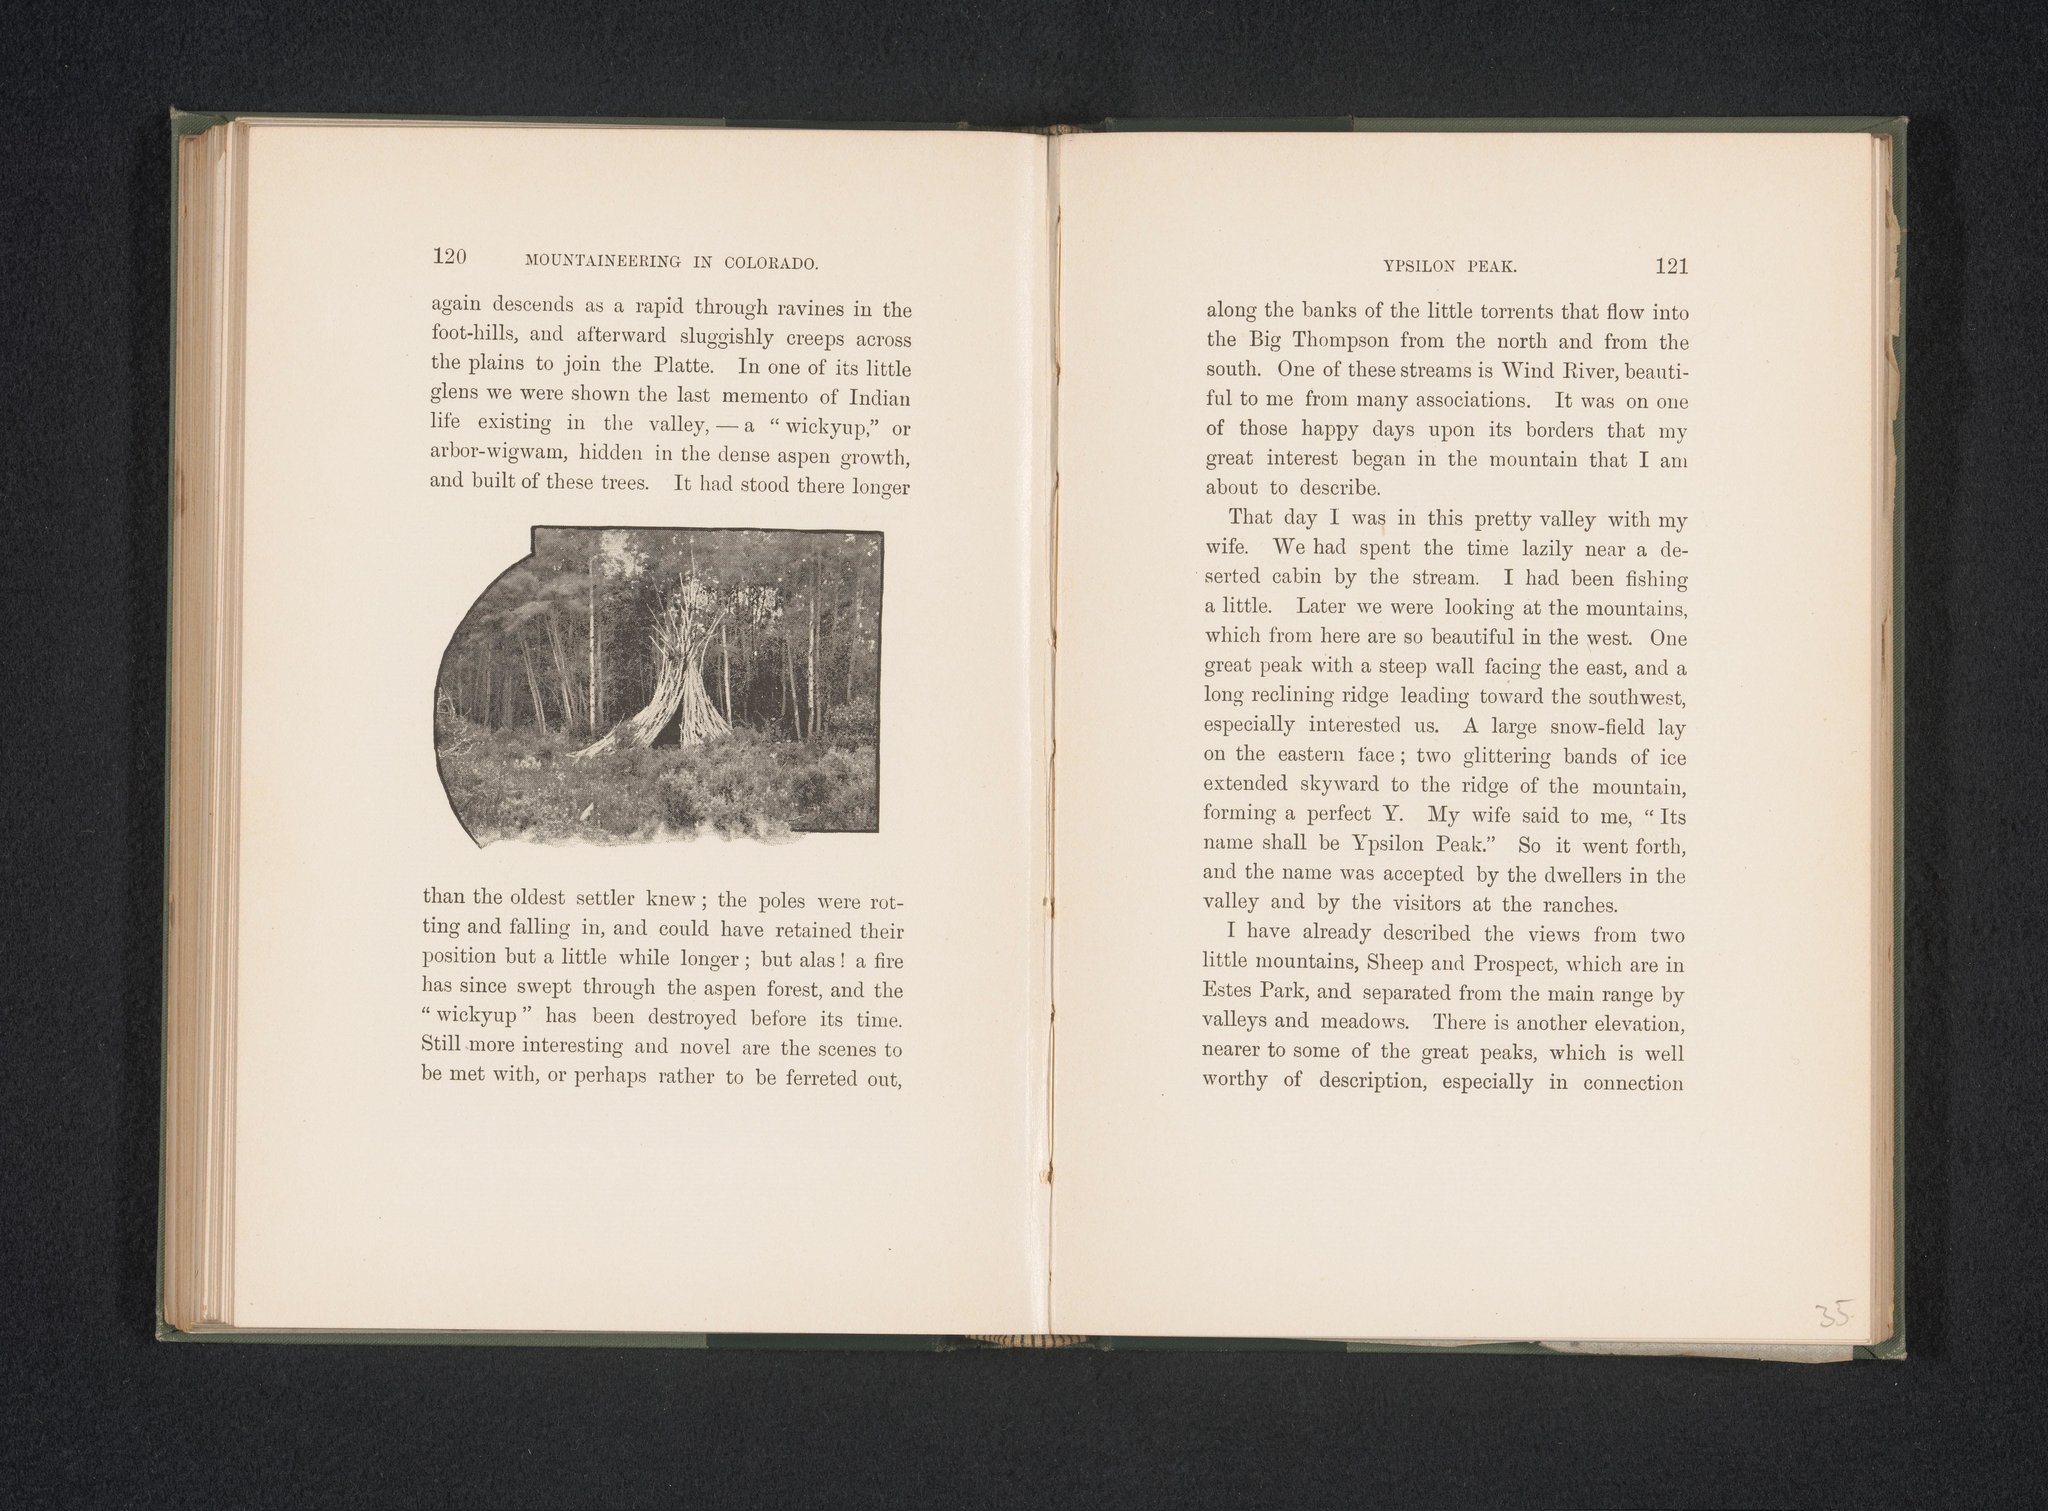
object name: photomechanical print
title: Gezicht op een bos met een wigwam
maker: frederick hastings chapin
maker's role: antropoloog, archeoloog, fotograaf, schrijver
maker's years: 1852-1900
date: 1885-1890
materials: paper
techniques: autotype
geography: rocky mountain national park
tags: wigwam, forest, wood